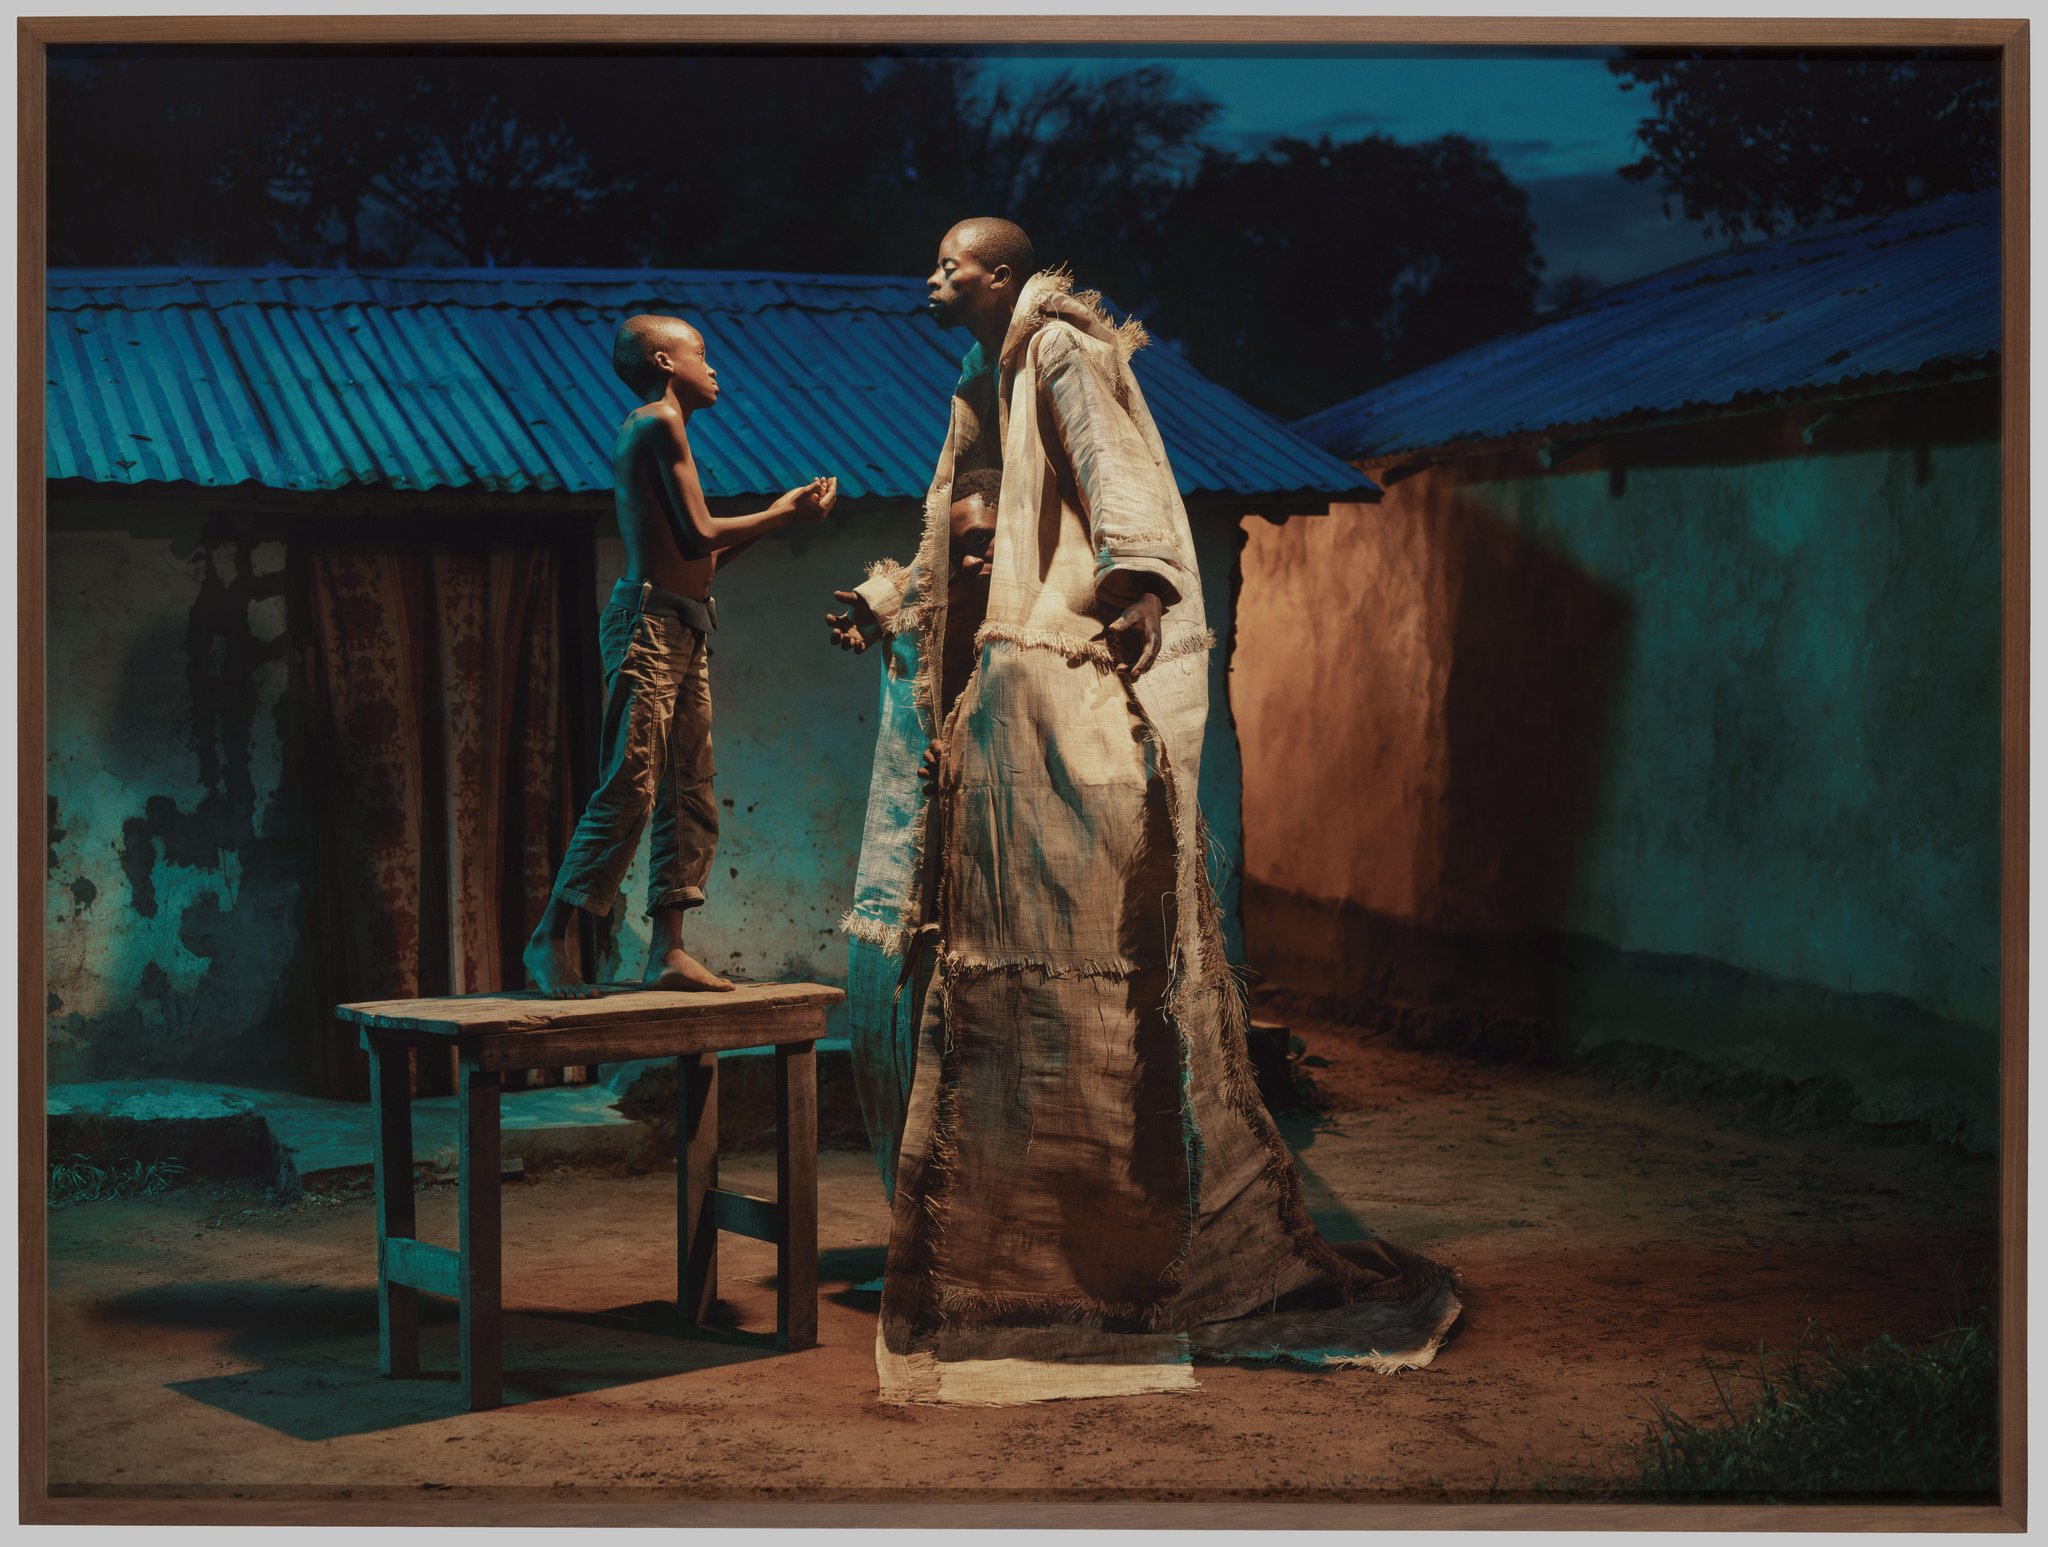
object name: photograph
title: Congo Tales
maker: pieter henket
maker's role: fotograaf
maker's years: 1979-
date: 2018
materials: glass, wood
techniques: inkjet print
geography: congo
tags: congo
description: De in New York wonende Nederlandse fotograaf Pieter Henket heeft met een team van Congolese schrijvers en filosofen de eigen volksverhalen uit de regio Mbomo in de Afrikaanse Republiek Congo tot leven gewekt en in beeld gebracht, als 're-enactments'. Zijn serie begon als project om Odzala-Kokoua National Park in het Congo Basin, in grootte het tweede tropische regenwoud ter wereld, te steunen in de strijd tegen klimaatverandering. Het werd uiteindelijk een project waarin de mensen en hun tradities en verhalen uit de regio centraal staan. De Congolezen figureerden zelf als acteurs in hun eigen mythes en verhalen die ze zelf regisseerden. Henket voerde het project met de Congolozen uit Mbomo uit, samen met en gesteund door het Sabina Platform African Charity-organisatie. Het project mondde uit in een tentoonstelling en een boek. De foto's zijn na de grote tentoonstelling in Europa aan het dorp 'teruggegeven' en in de bibliotheek gehangen. De opbrengsten van een grote veiling zijn eveneens naar het dorp teruggegaan.